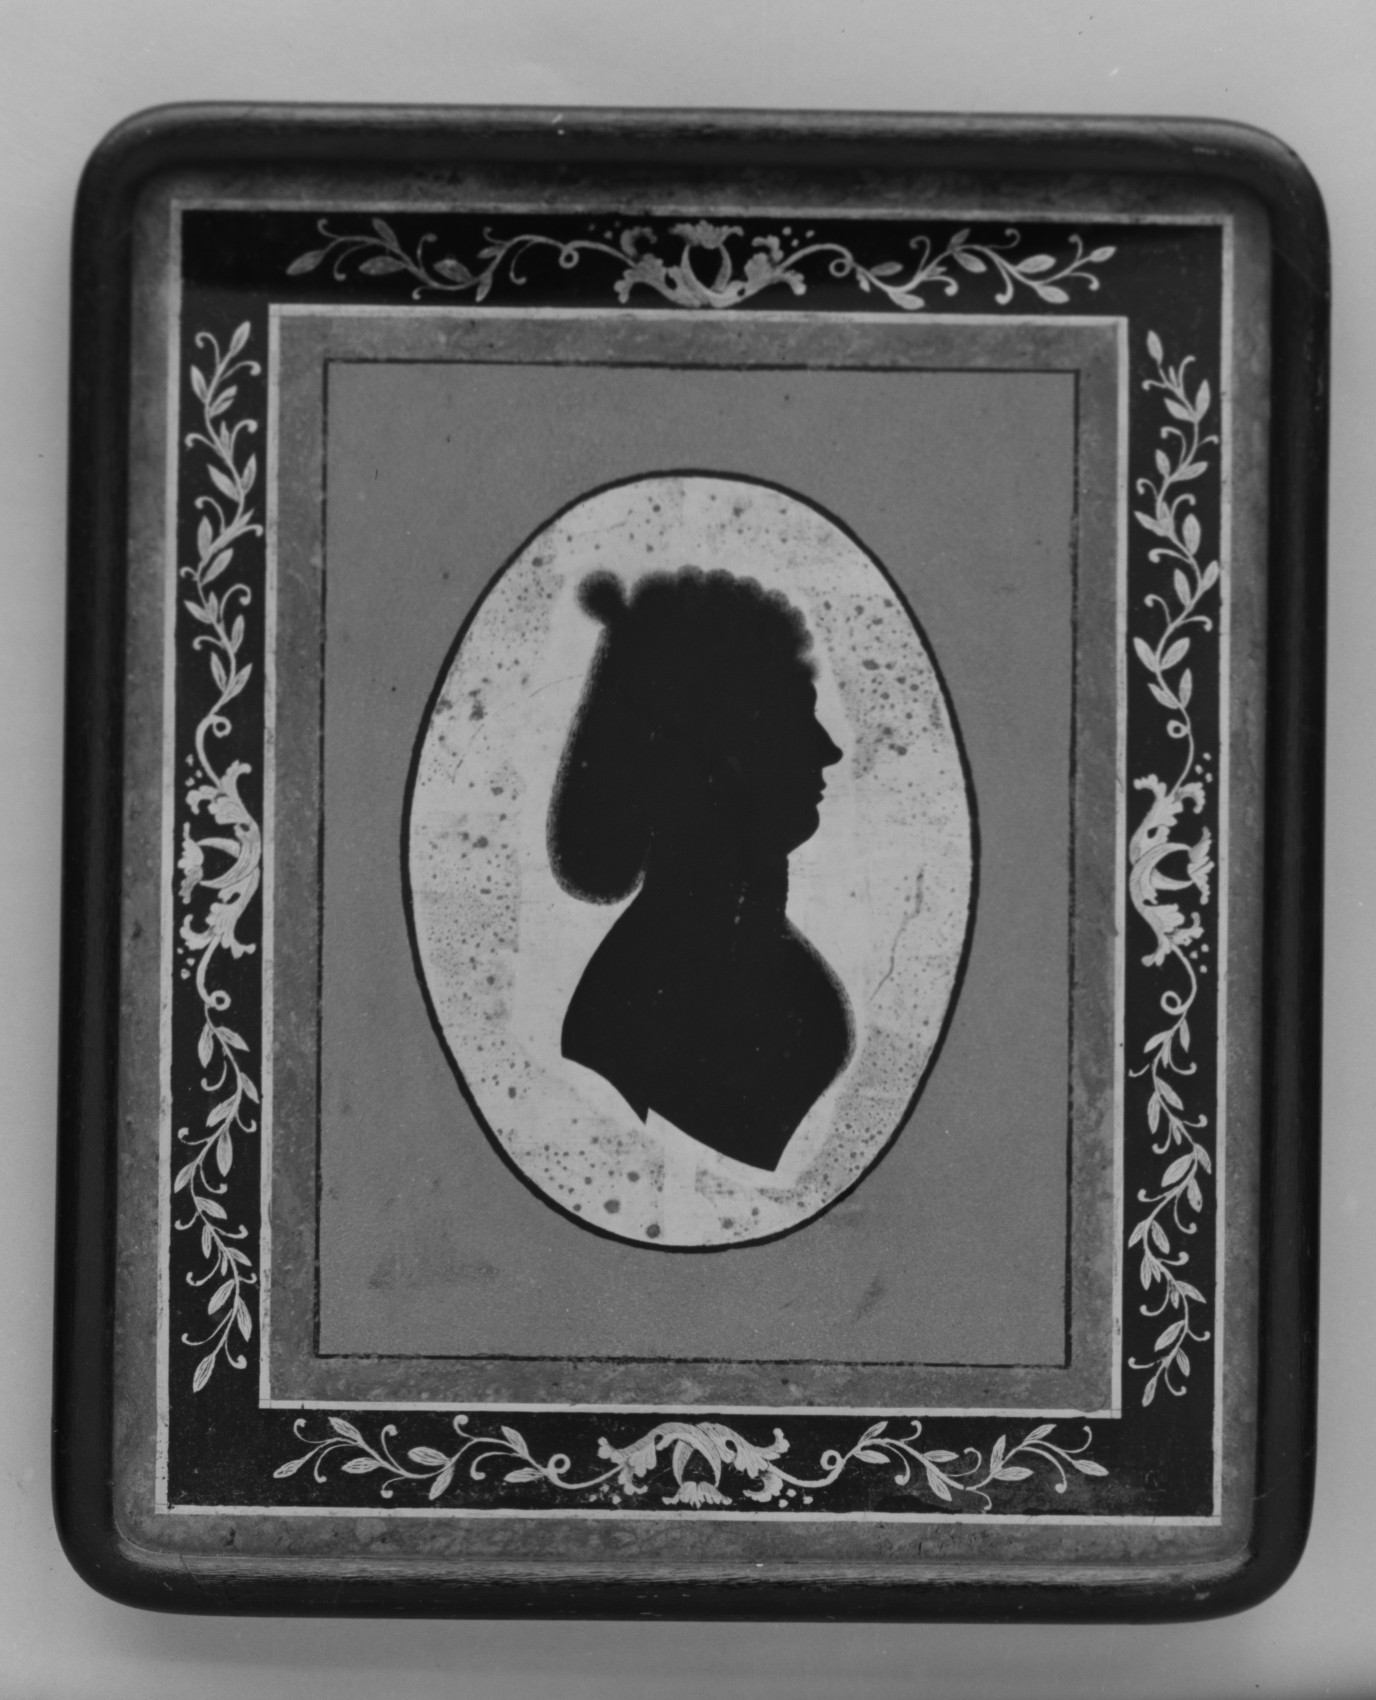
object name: panel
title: Countess Cantacuzene (one of a pair)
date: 1701-1800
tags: profiles